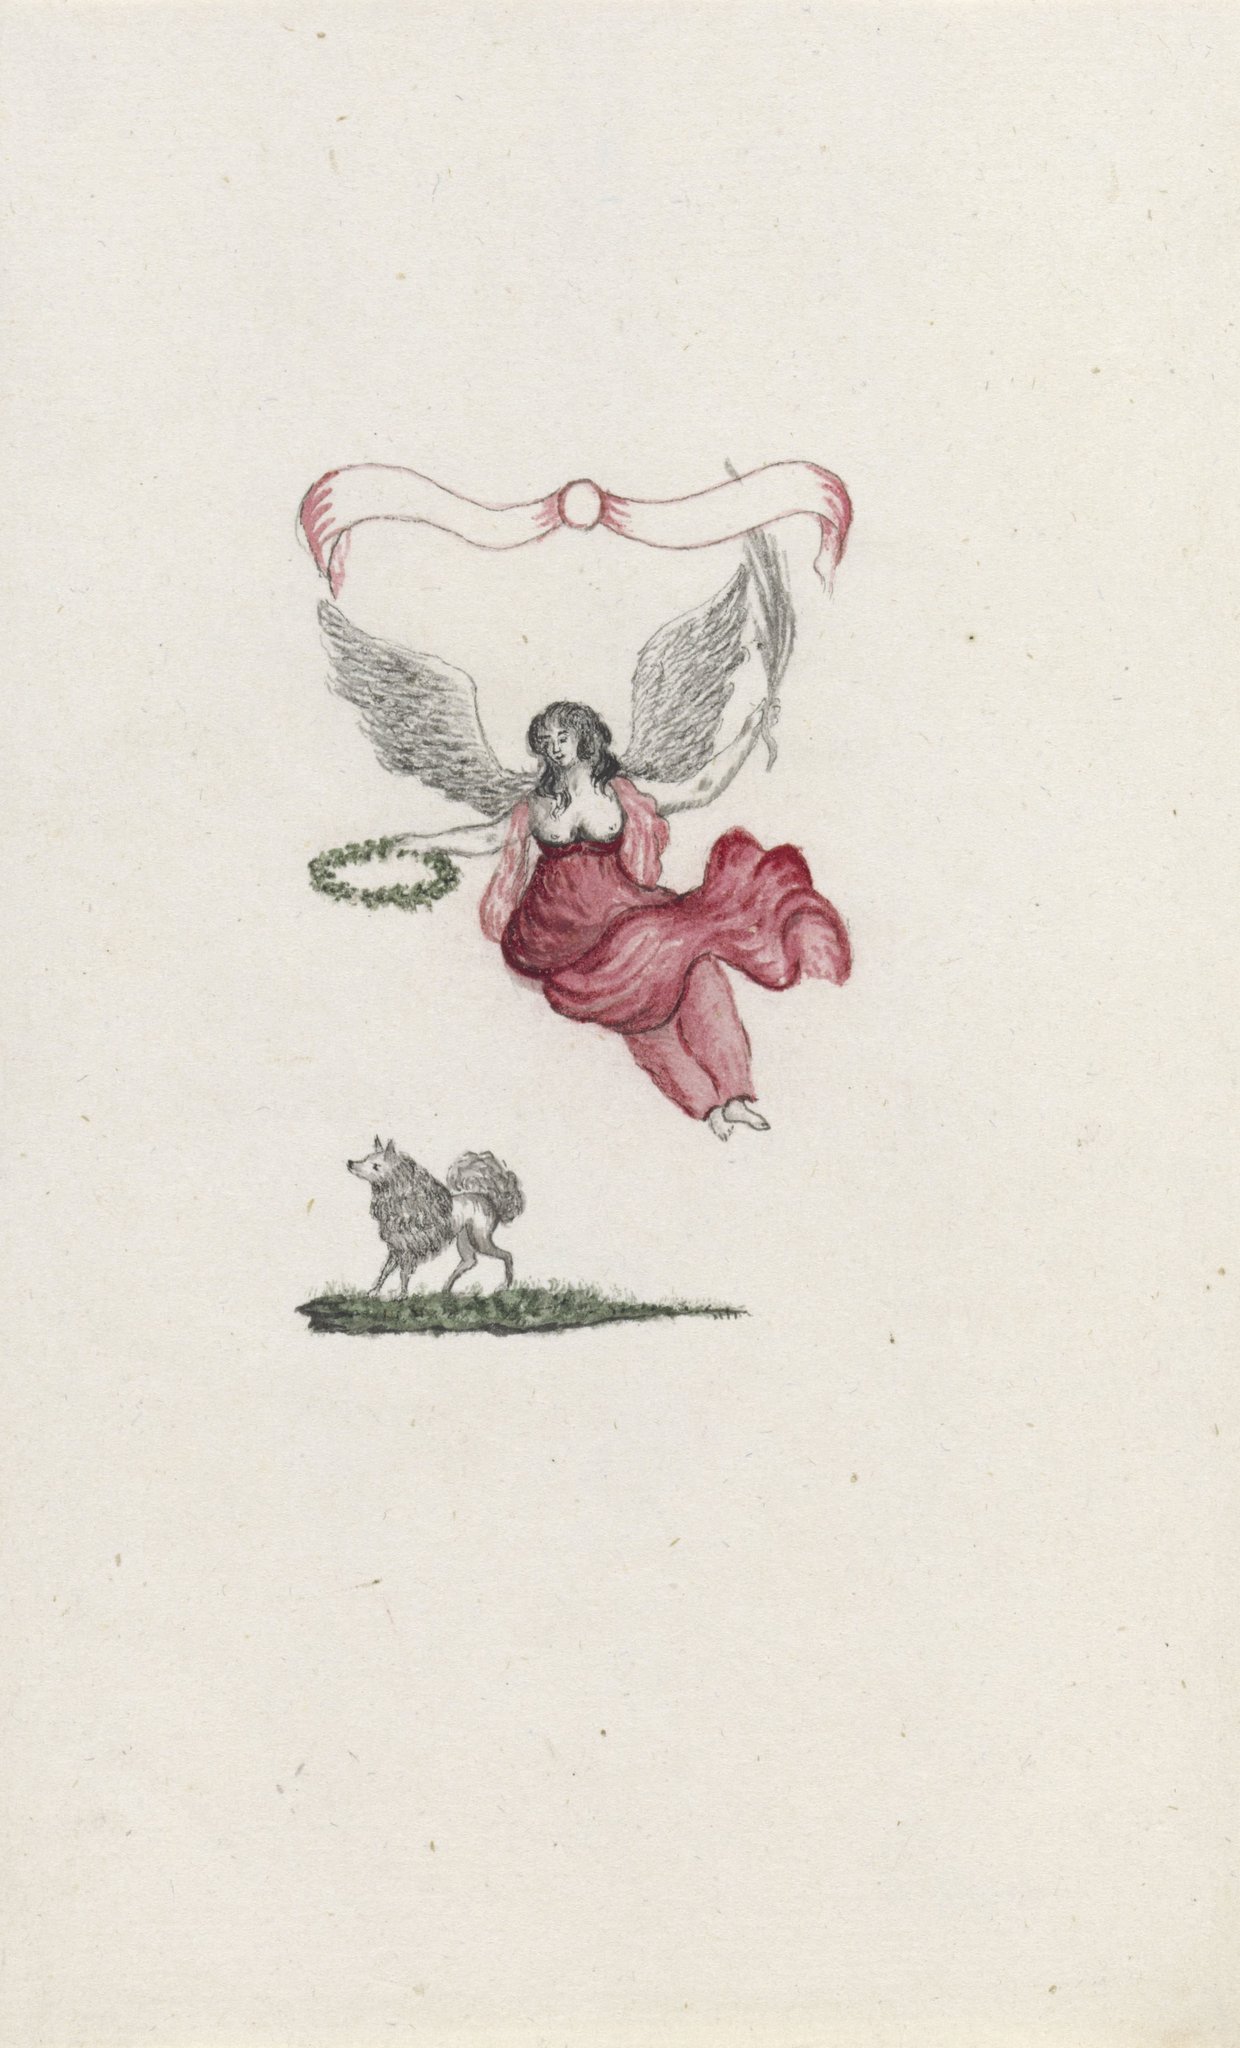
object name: drawing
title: Vignet met keeshond, 1795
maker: Anonymous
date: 1795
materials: paint, paper, pencil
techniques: brush, pen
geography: netherlands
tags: dog, alliance with france (1795)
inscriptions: collector's mark: Lugt 2228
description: Vignet met een keeshond die door een engel wordt gelauwerd. Bovenaan een roze strik. Onderdeel van een groep van zes getekende vignetten, mogelijk voor chasinetten bij een feest ter gelegenheid van de alliantie met Frankrijk in 1795.